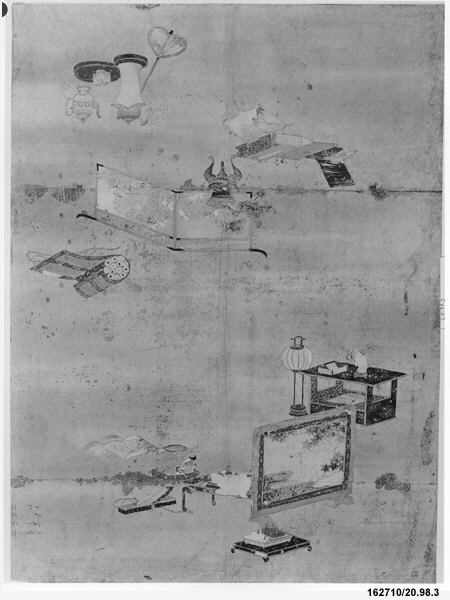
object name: textile design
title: Textile Design for Stencil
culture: japanese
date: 1601-1700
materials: paint, paper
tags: tables